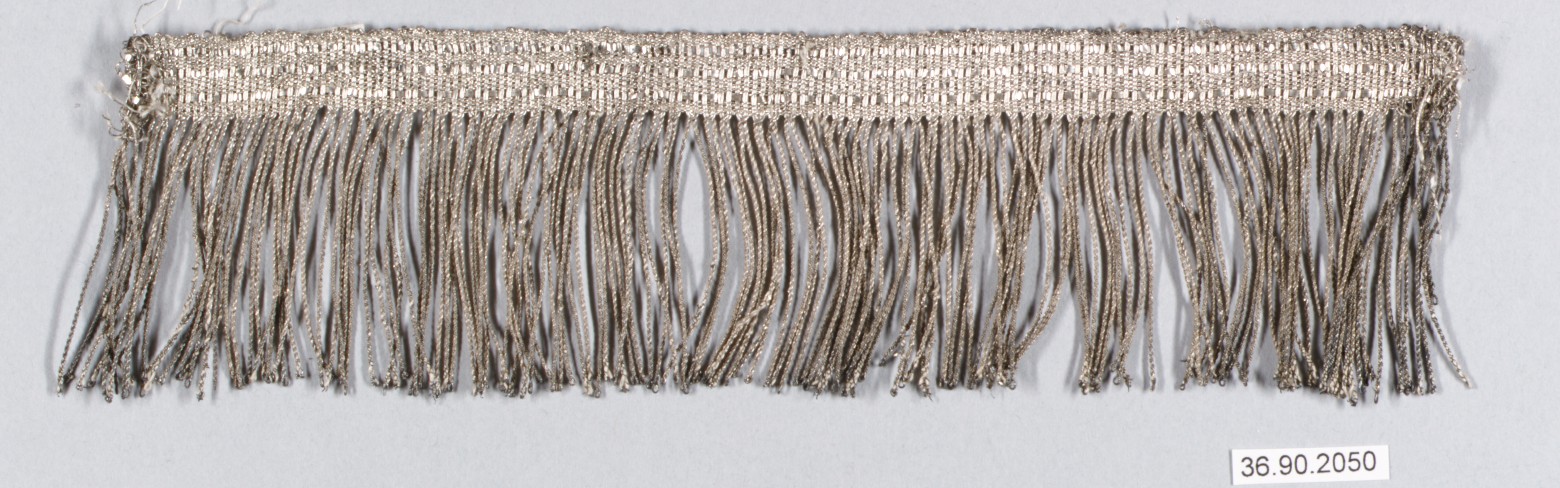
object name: fringe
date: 1701-1800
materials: silk